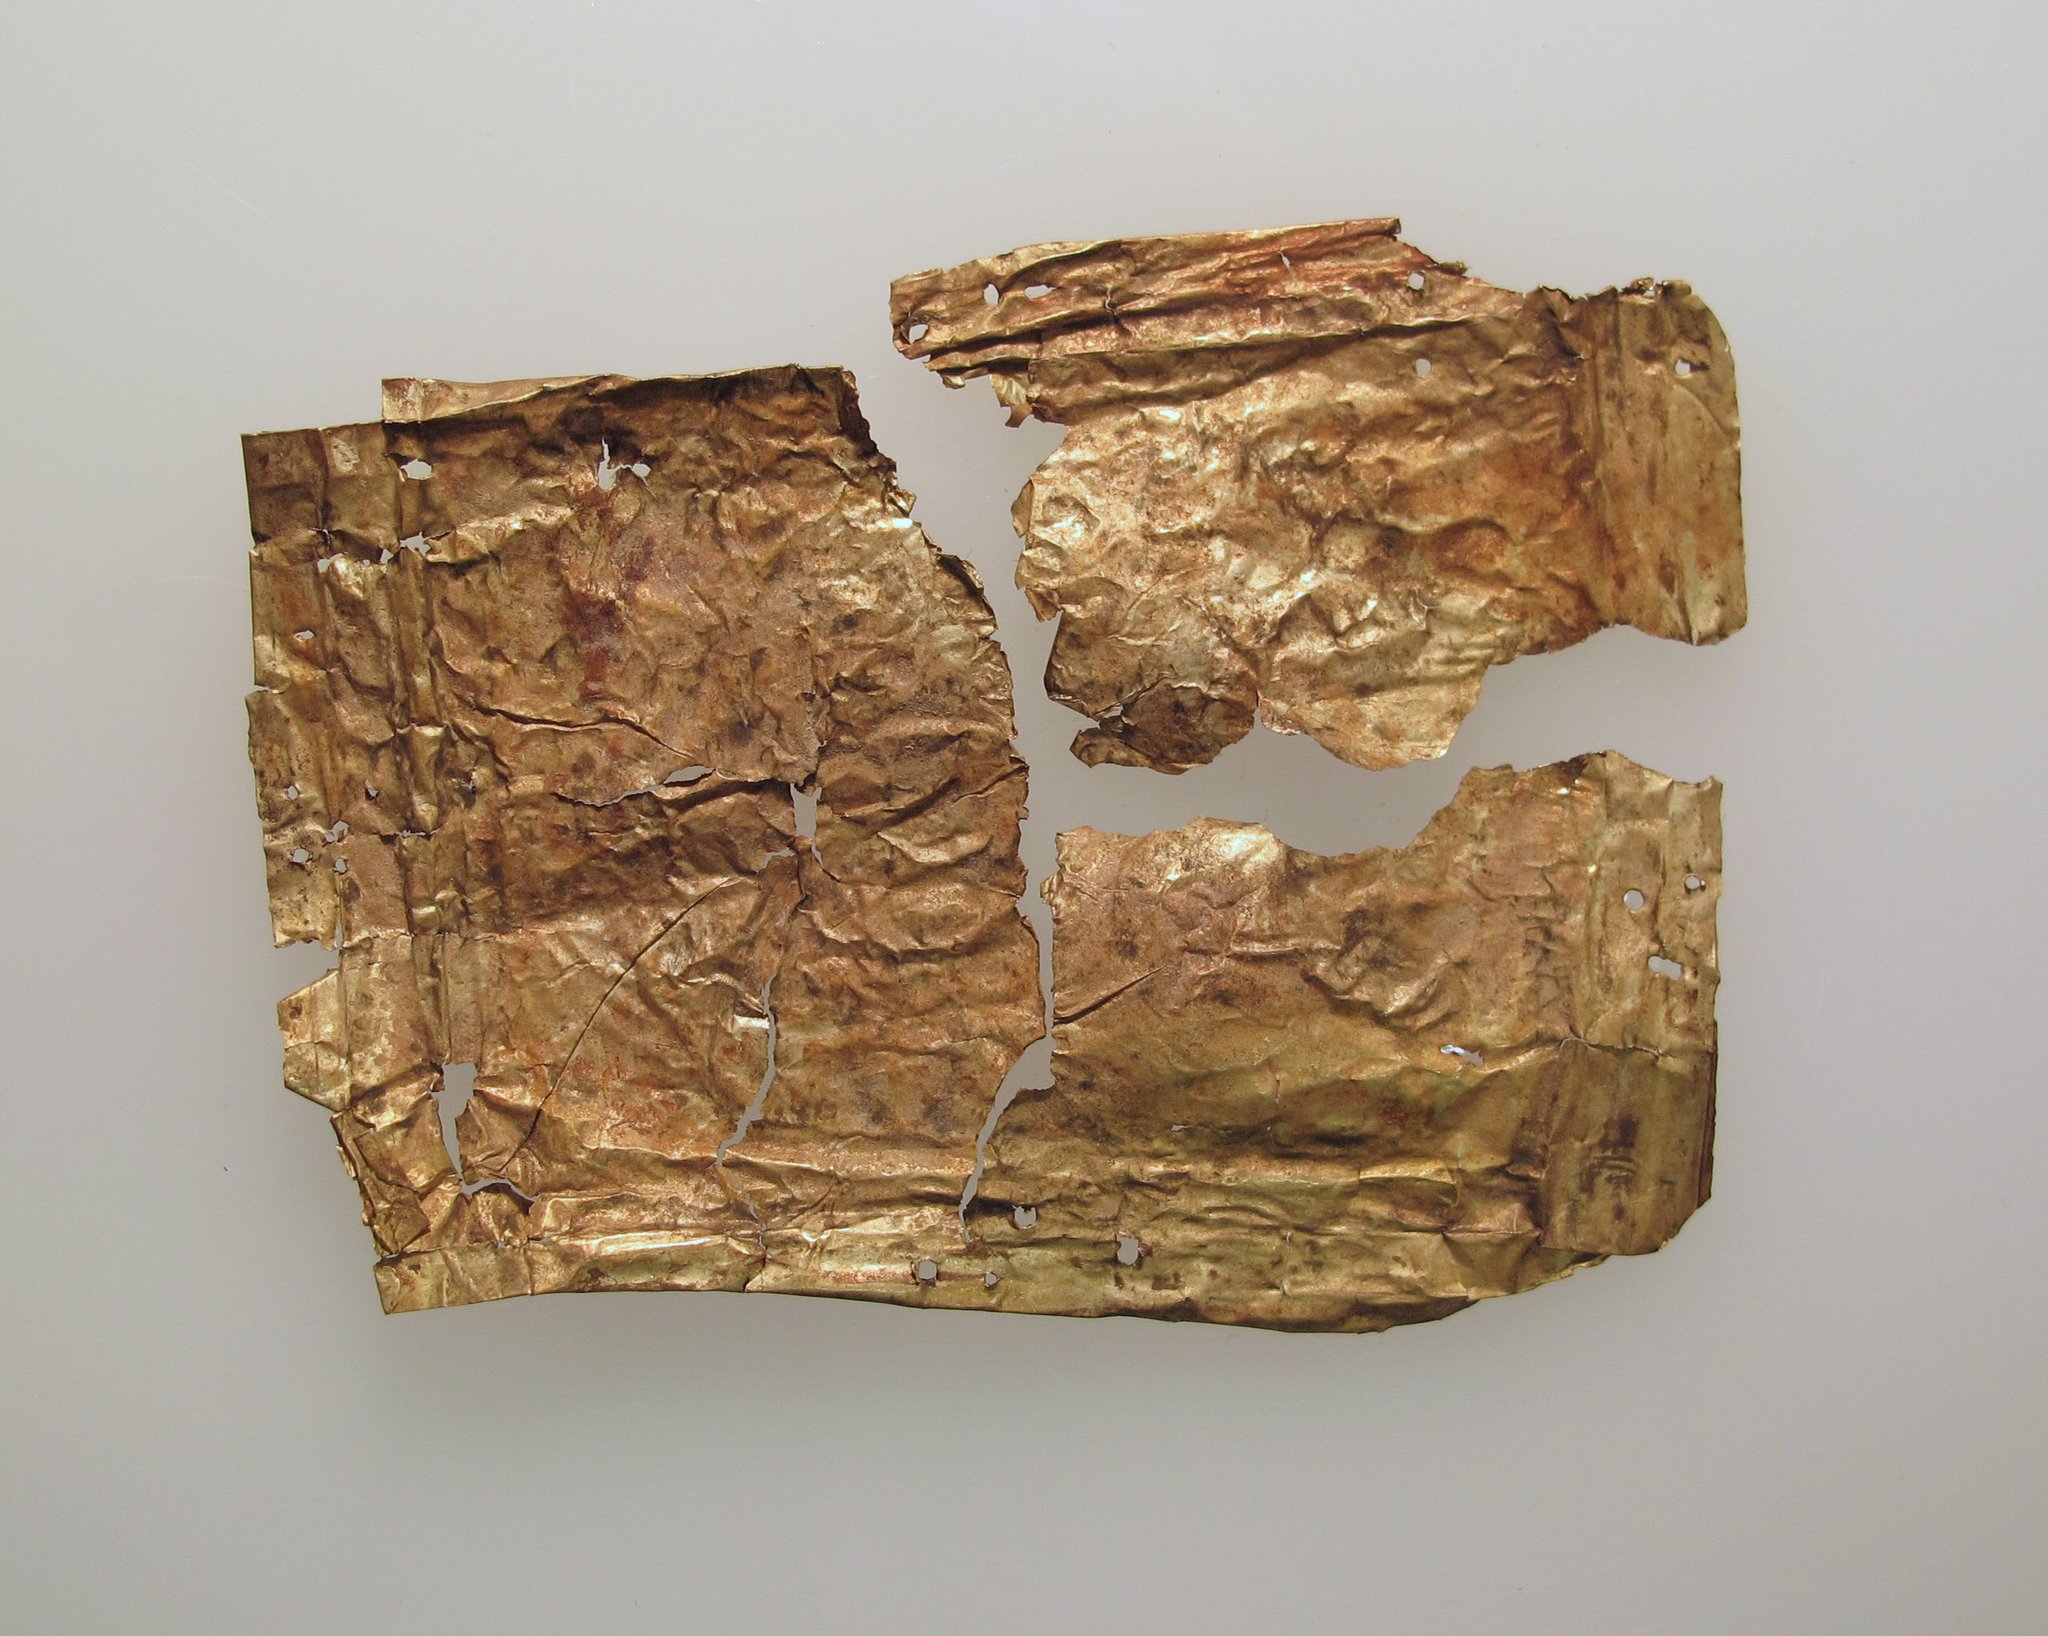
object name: plaque, thin gold leaf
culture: cypriot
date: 3900 BCE-100 CE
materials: gold